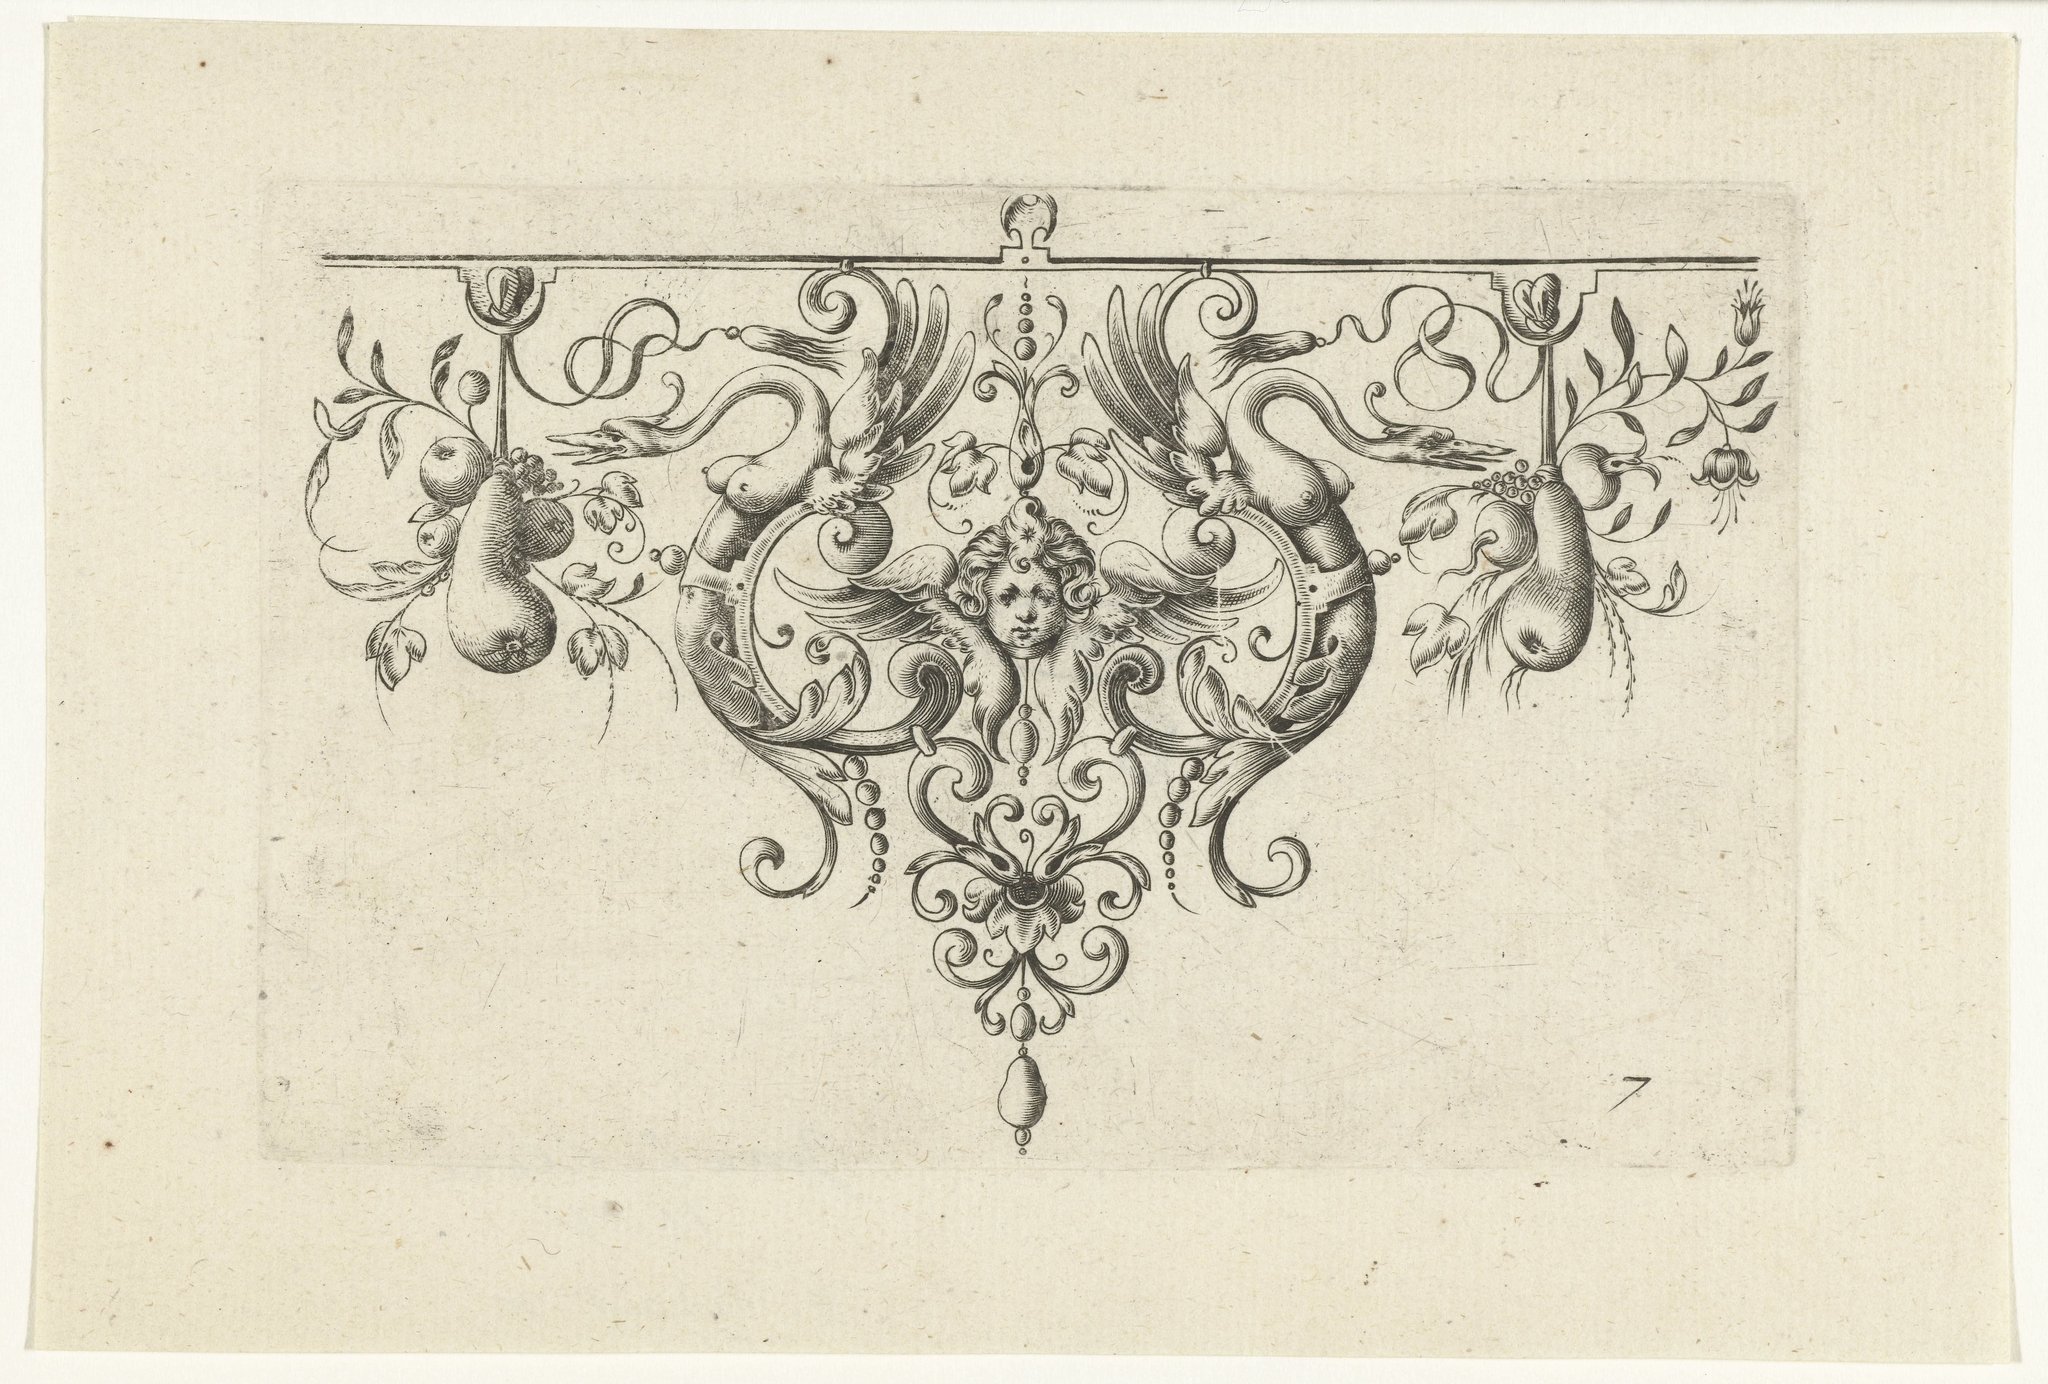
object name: print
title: Randornament met cherubijn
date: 1618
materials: paper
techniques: engraving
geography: paris